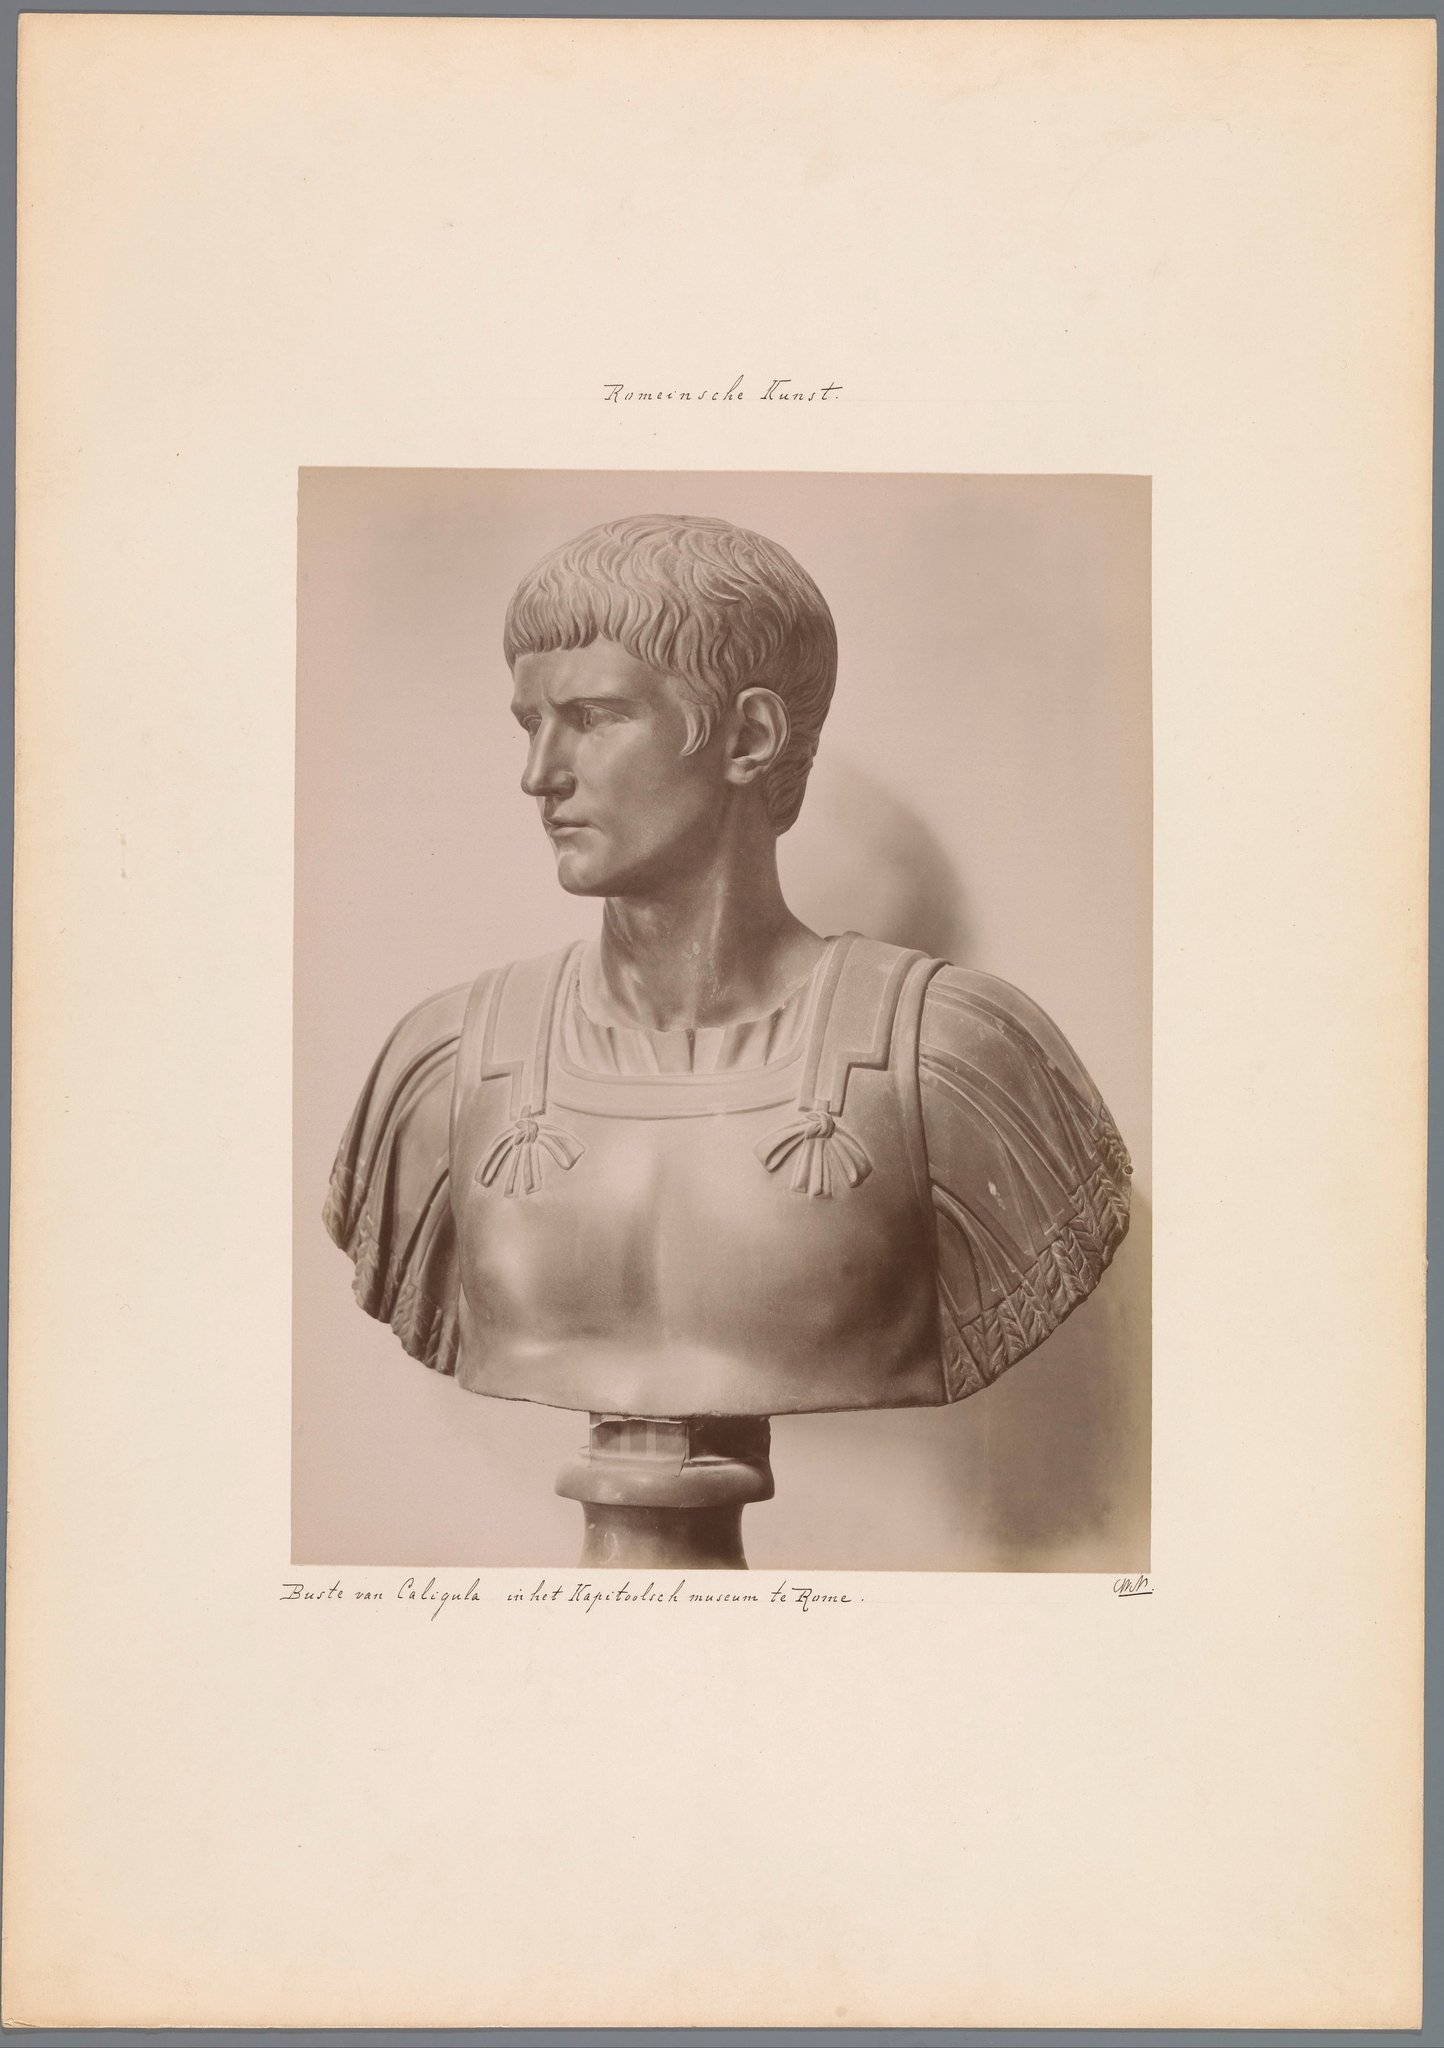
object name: photograph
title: Buste van Caligula uit het Kapitoolsch museum te Rome.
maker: Anonymous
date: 1875-1900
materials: cardboard, photographic support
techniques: albumen print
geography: europe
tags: male persons from classical history (+ head, bust, etc.), 98b(caligula, gaius)9 male persons from classical history (caligula, gaius) - portrait of person from classical history, piece of sculpture, reproduction of a piece of sculpture, europe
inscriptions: collector's mark: ‘INSTITUUT VOOR KUNST-NIJVERHEIDSONDERWIJS GABRIËL METSUSTRAAT No. 16 AMSTERDAM’, inscription: ‘Romeische Kunst.’, collector's mark: ‘KUNSTNIJVERHEIDSCHOOL QUELLINUS AMSTERDAM FRANS HALSSTRAAT 14.’, inscription: ‘CWN.’